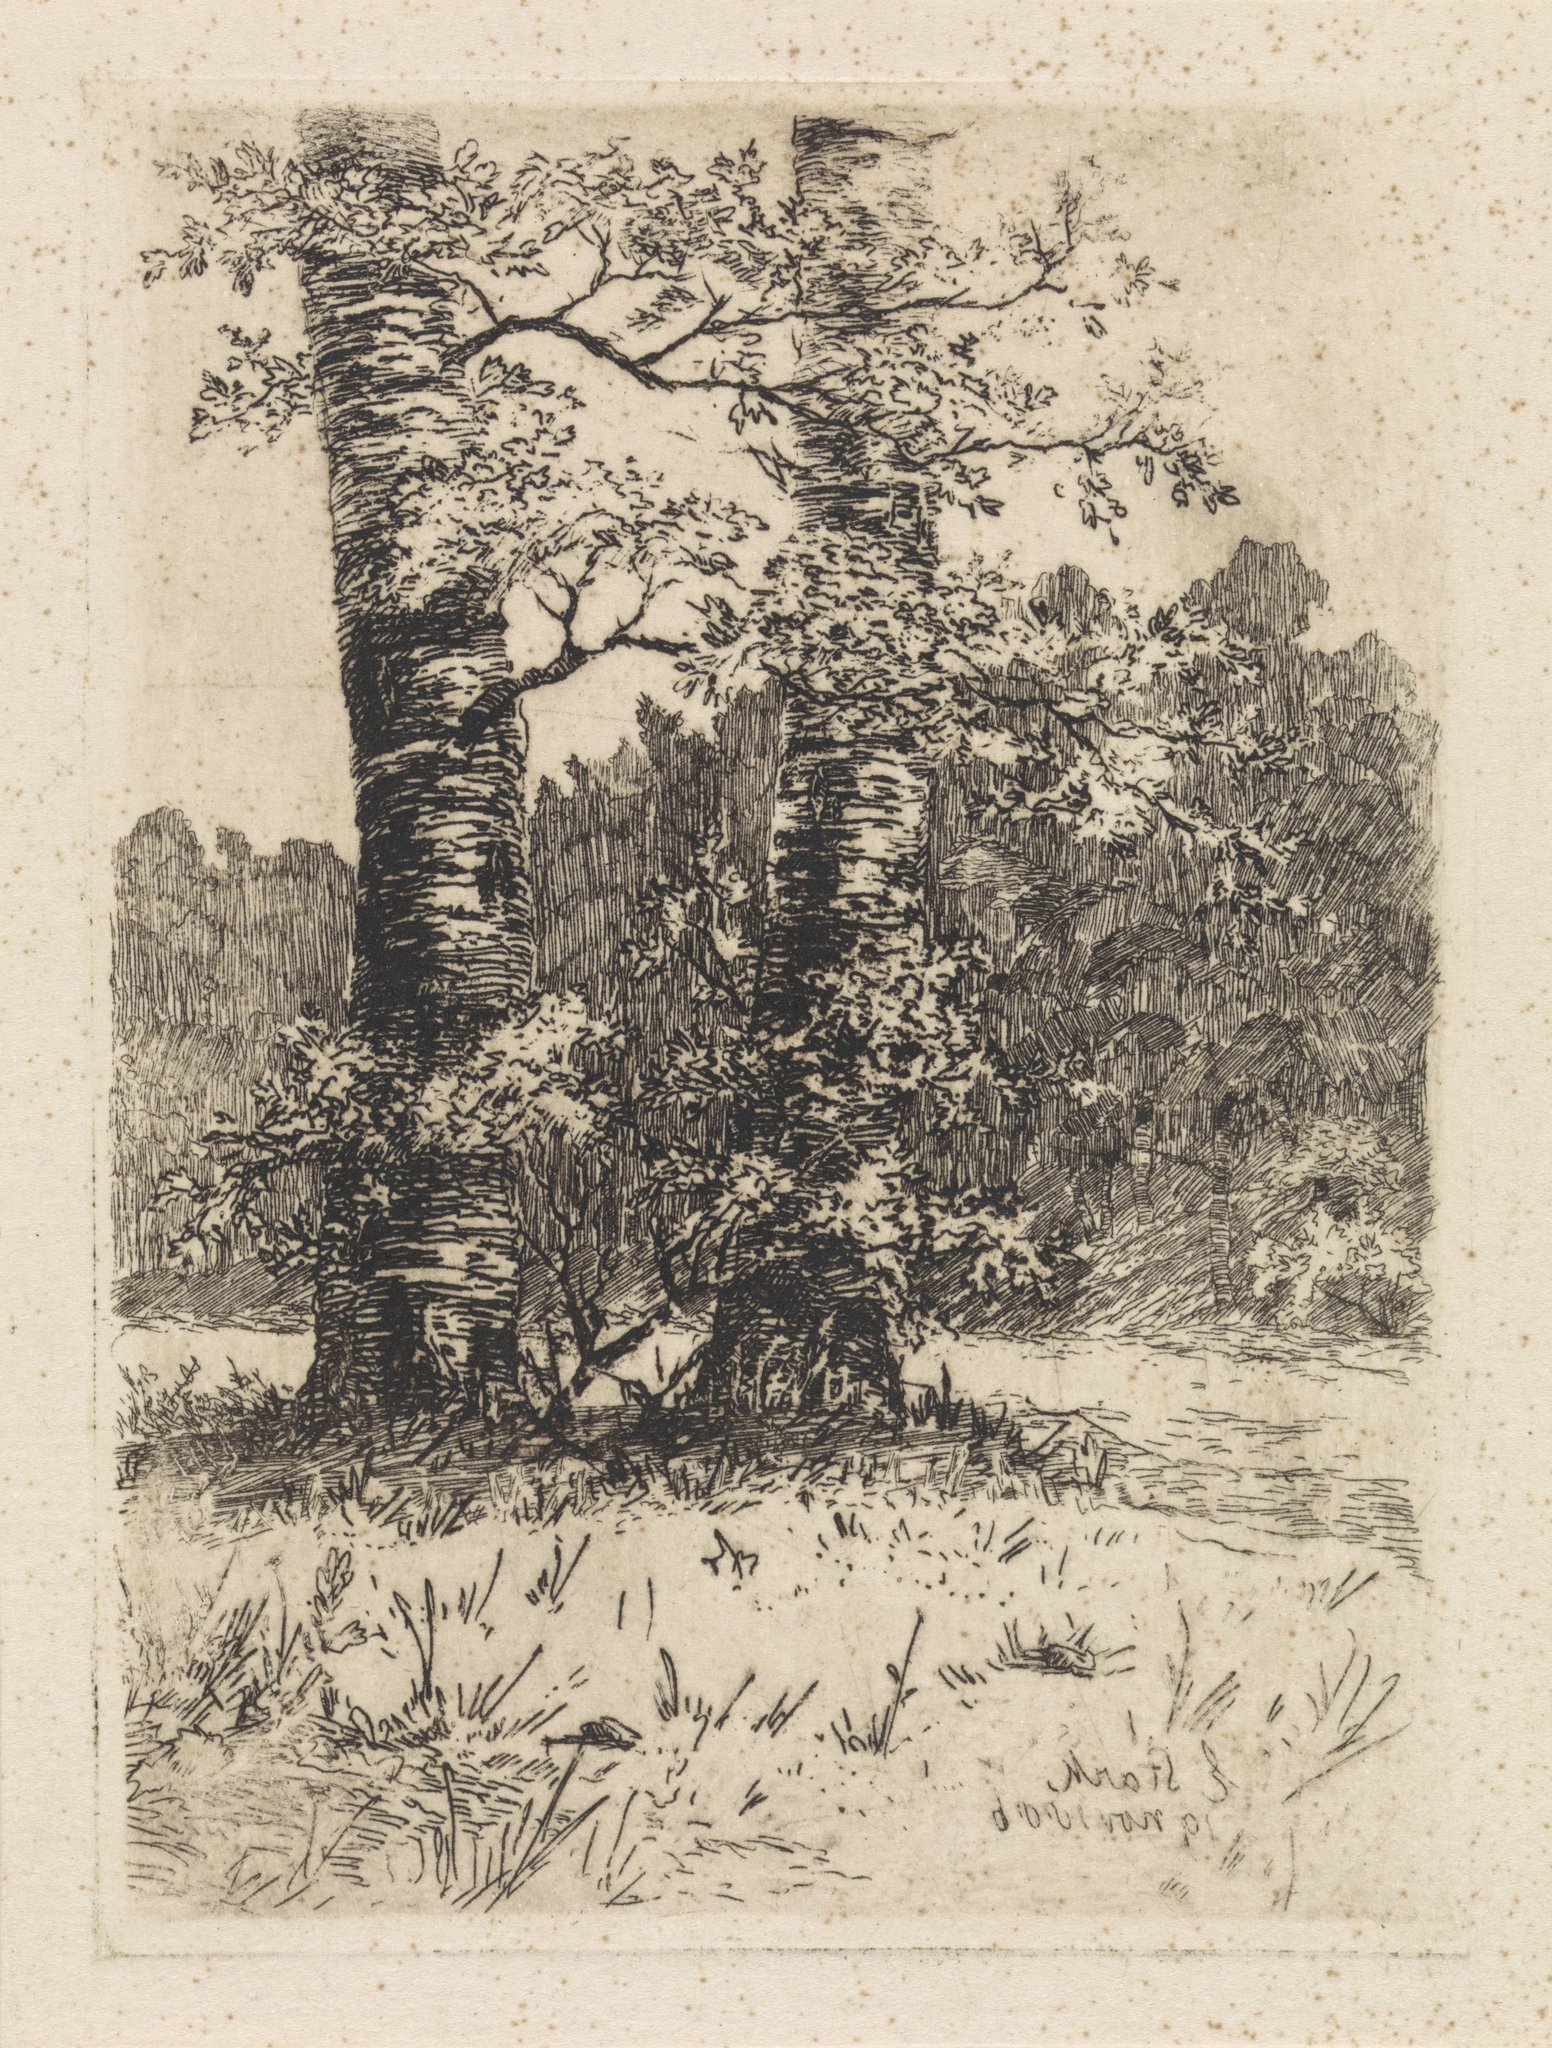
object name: print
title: Twee bomen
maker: elias stark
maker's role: draughtsman, print maker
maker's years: 1849-1933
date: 1886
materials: paper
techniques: etching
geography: nieuwer-amstel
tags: trees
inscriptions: collector's mark: Lugt 2228